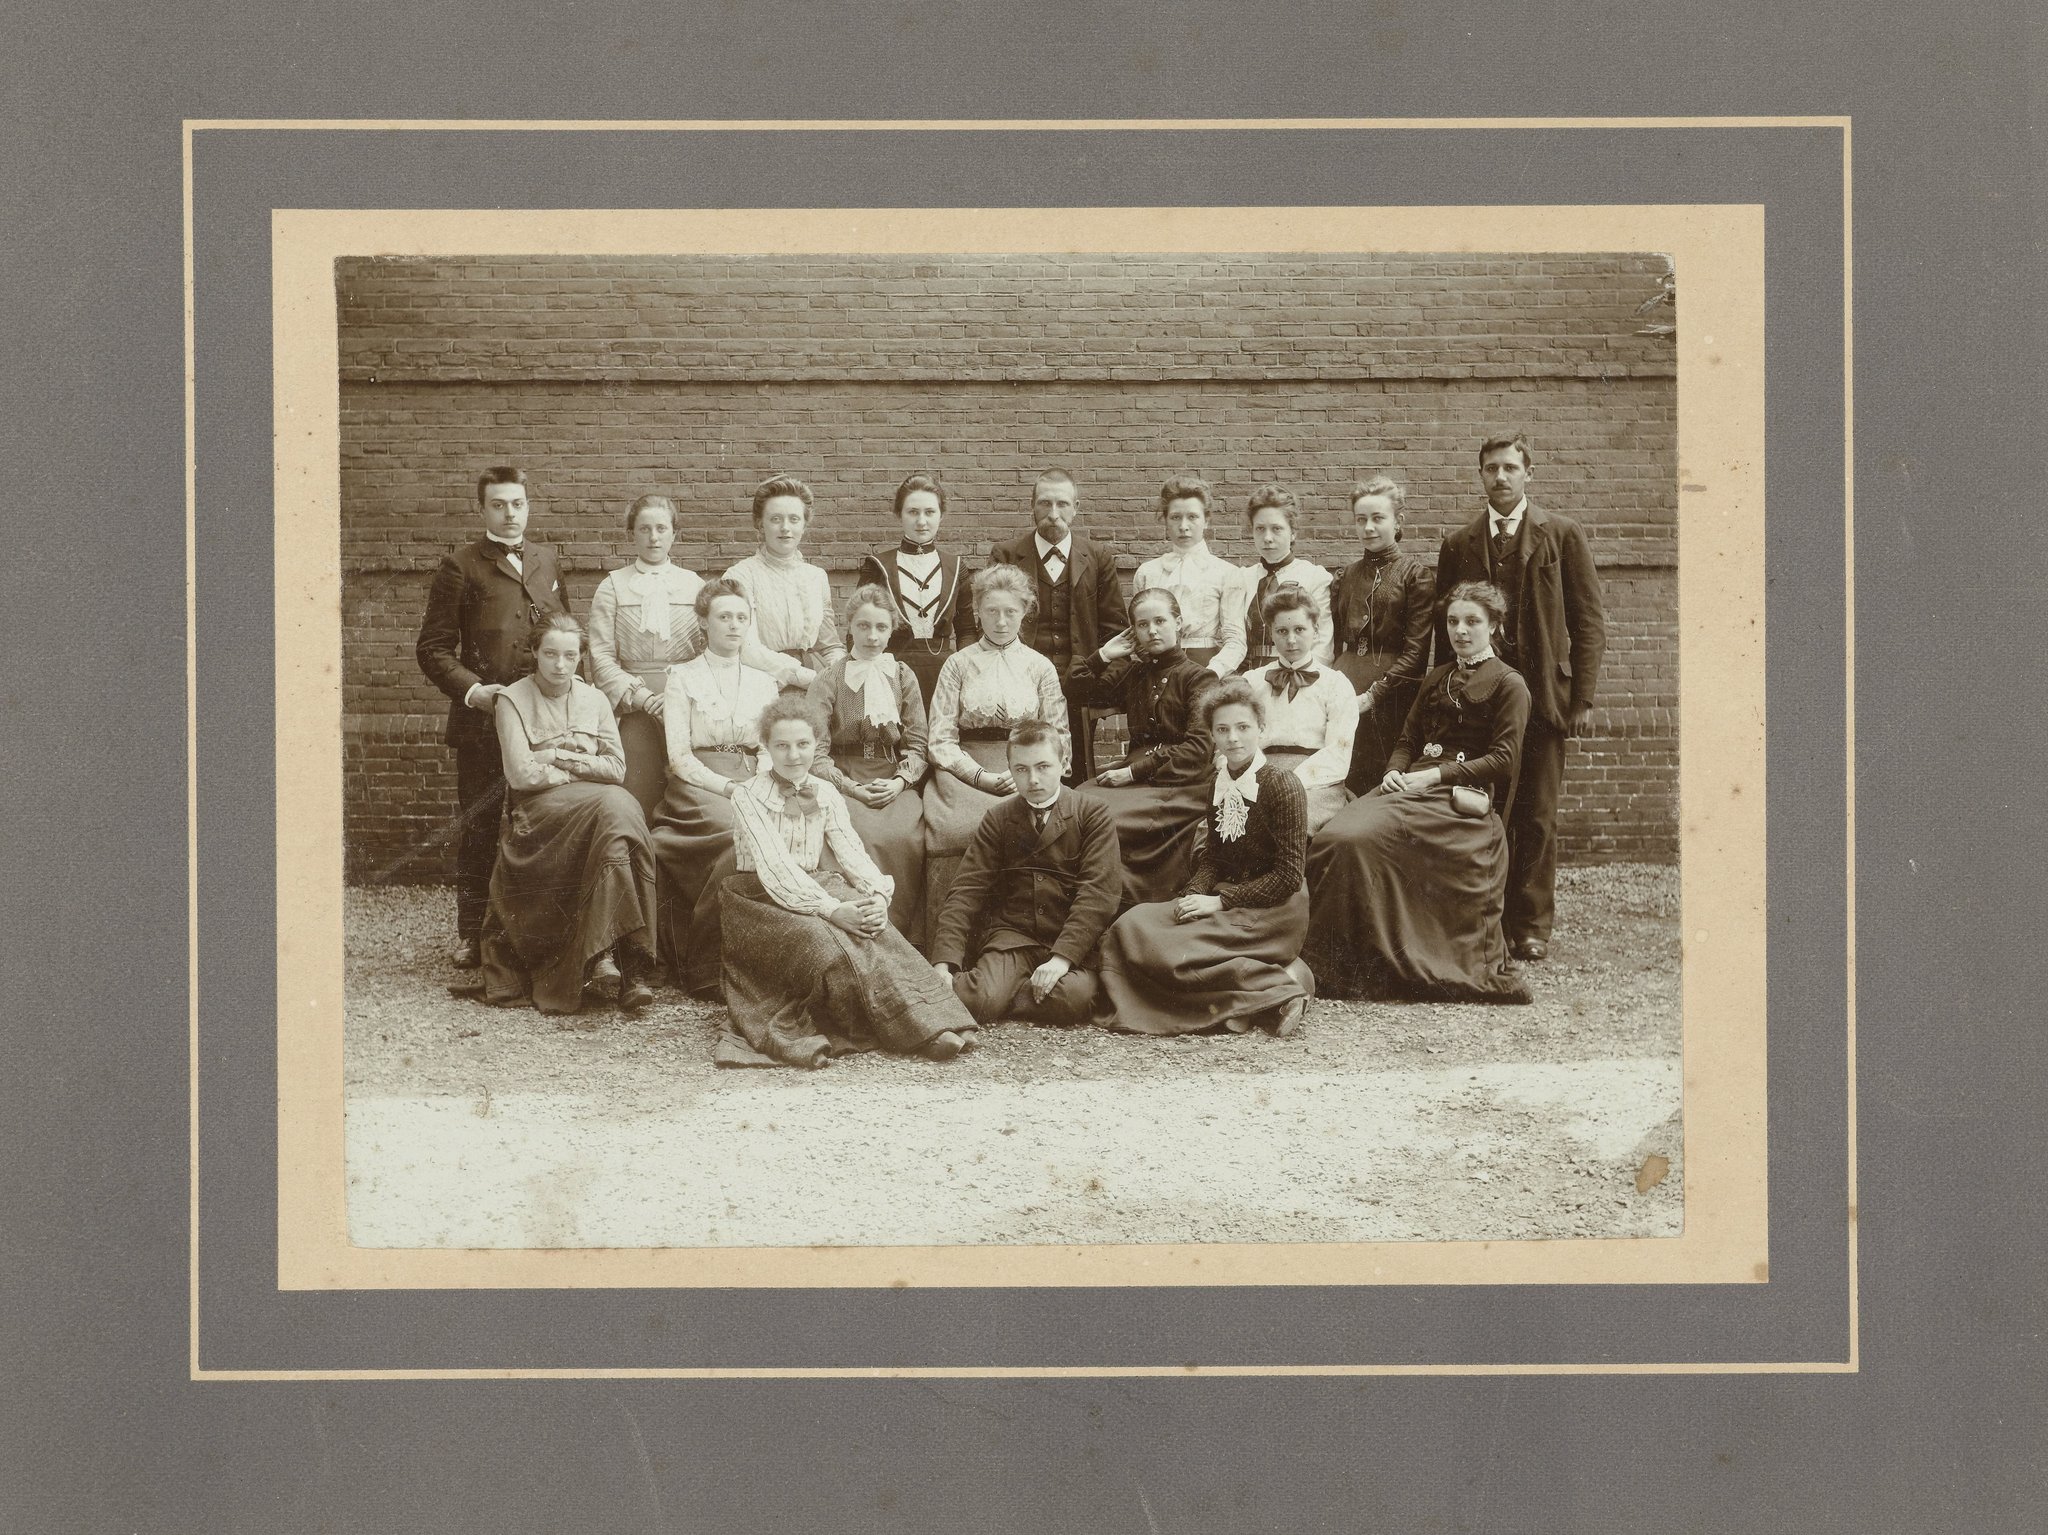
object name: photograph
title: Groepsportret van jonge mannen en vrouwen voor een muur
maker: p.d. van rhijn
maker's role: fotograaf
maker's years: 1874-1942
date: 1905-1915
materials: cardboard, paper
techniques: collodion silver print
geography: amsterdam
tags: anonymous historical persons portrayed in a group, in a group-portrait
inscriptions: stamp: ‘P.D van Rhijn photographie Amsterdam’